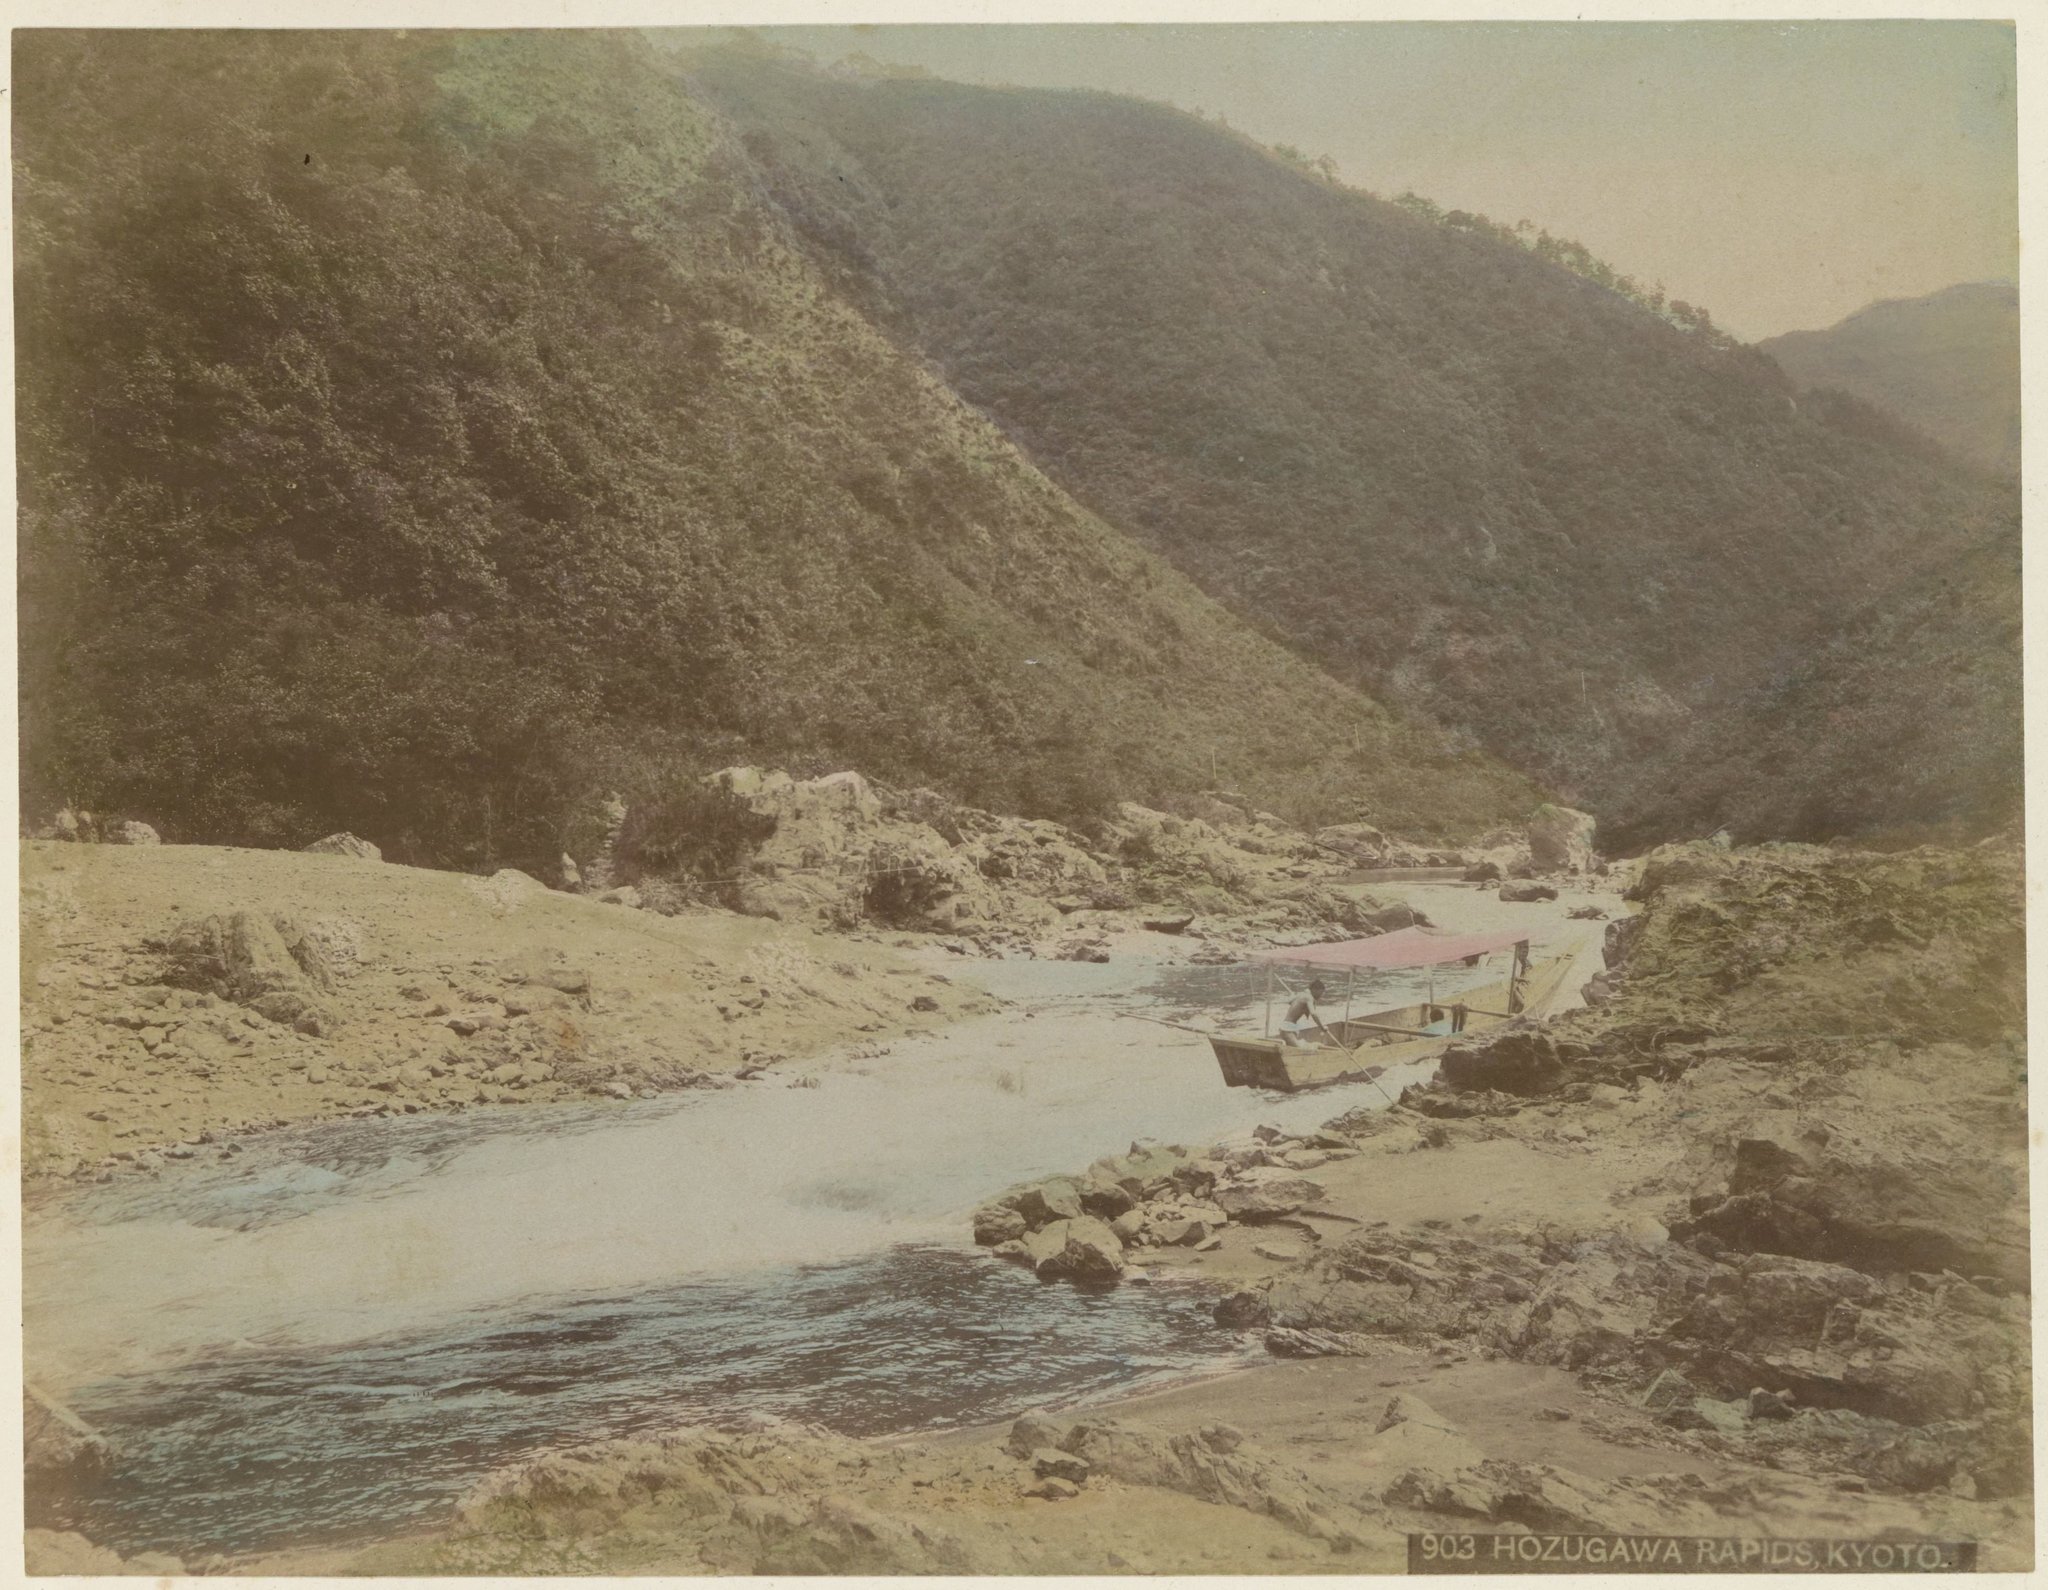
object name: photograph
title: Vissersboot in de stroomversnellingen van de Hozurivier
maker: Anonymous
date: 1870-1900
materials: cardboard, paper, photographic support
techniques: albumen print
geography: kyoto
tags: kyoto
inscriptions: negative number: ‘903’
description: Onderdeel van Reisalbum met foto's van bezienswaardigheden in Japan.